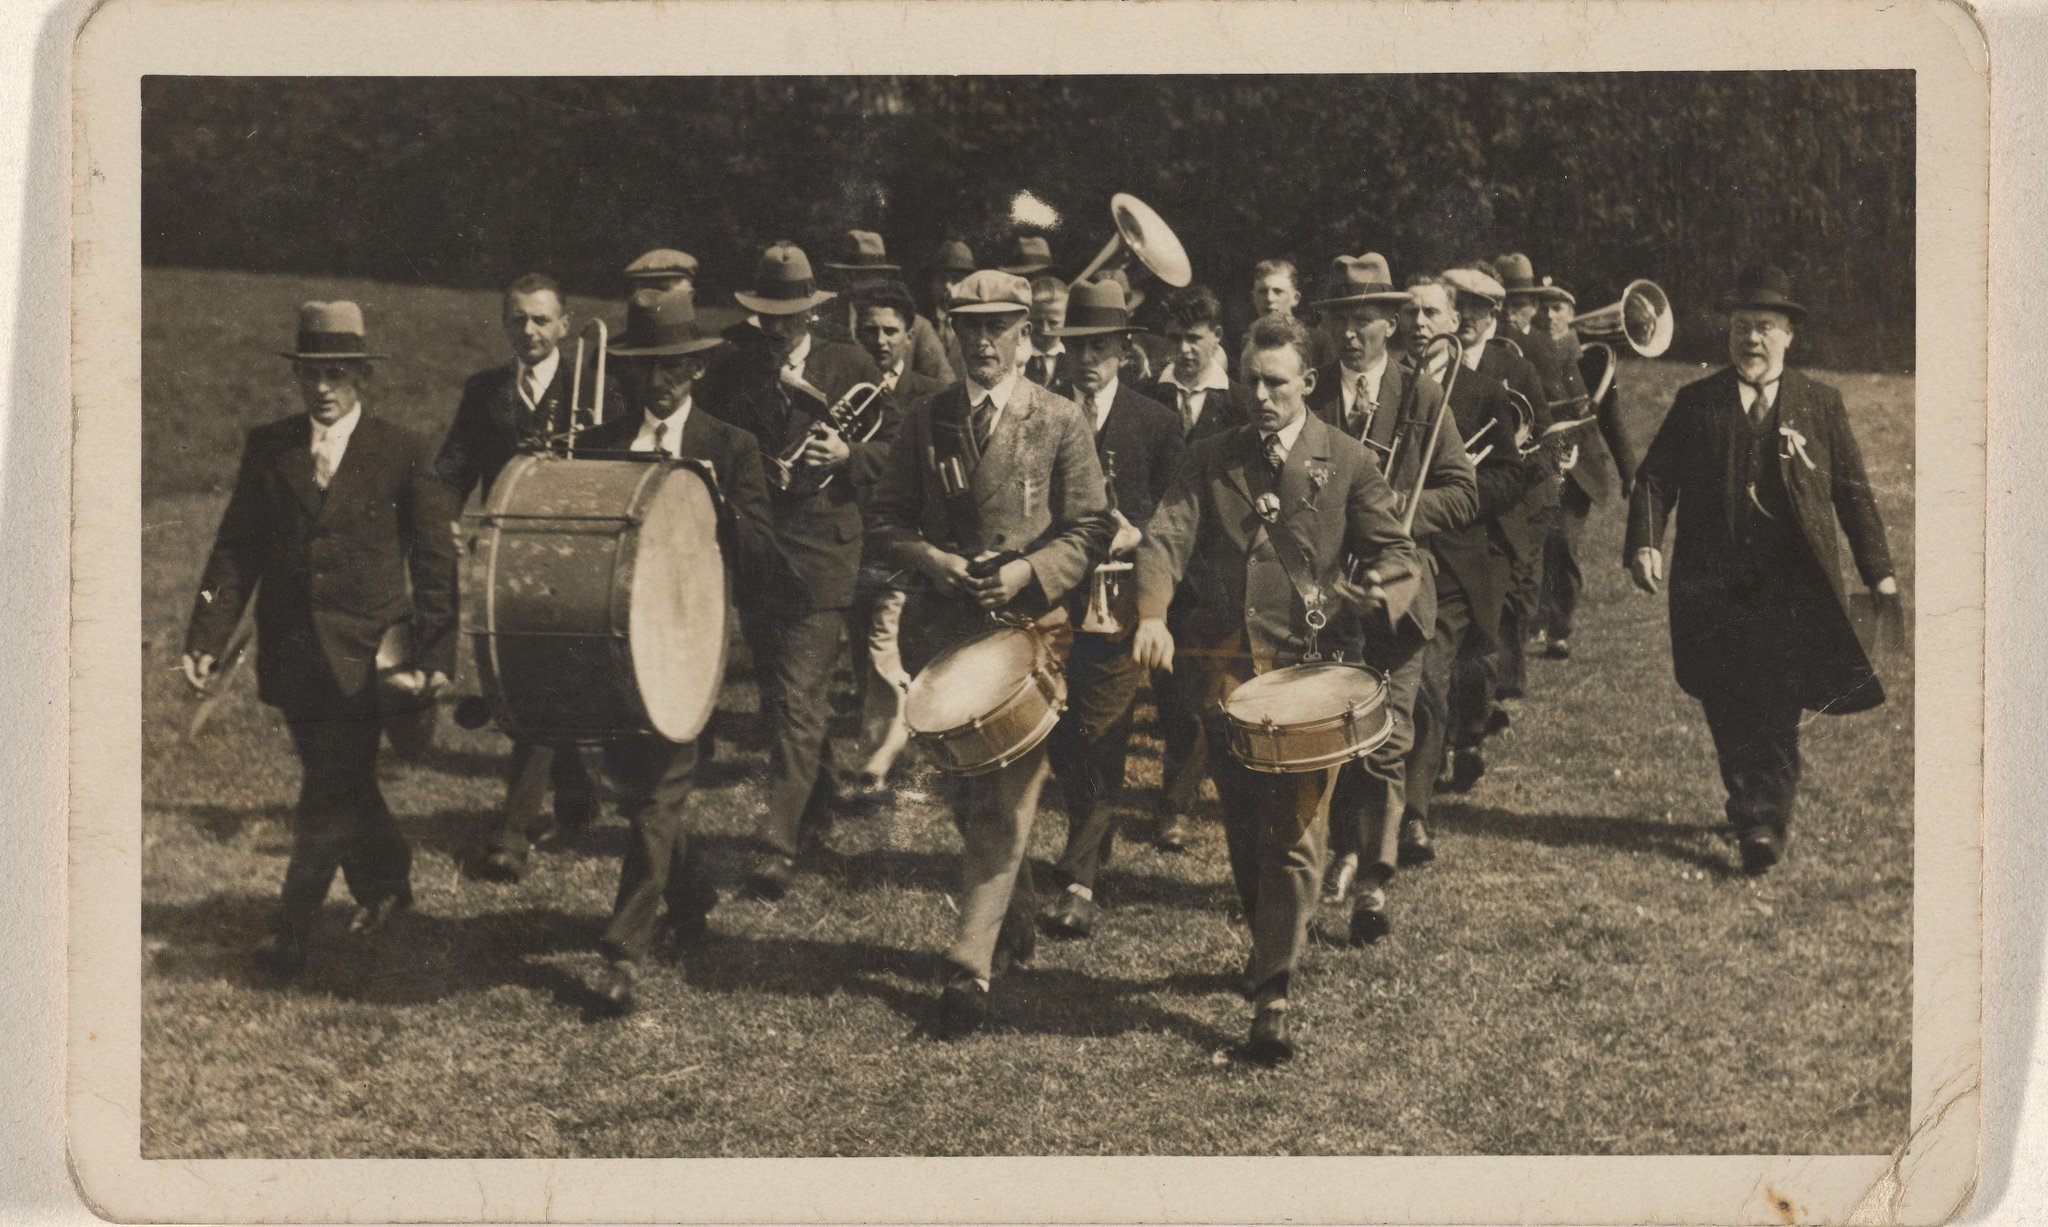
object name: photograph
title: Baambrugger Muziekvereniging 'Crescendo' op pad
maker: Anonymous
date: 1925-1935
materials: photographic support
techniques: gelatin silver print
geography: netherlands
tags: musical instruments; group of musical instruments, more than one musician with instrument, netherlands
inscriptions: annotation: ‘Baambrugger muzeikver. Crescendo. Met o.a. dirigent L. Dokkum groter trommeldrager J. Verwey, bekkenslager v. Vliet, Kleine trom v. Rossum en Moen bas J. Eindhoven’